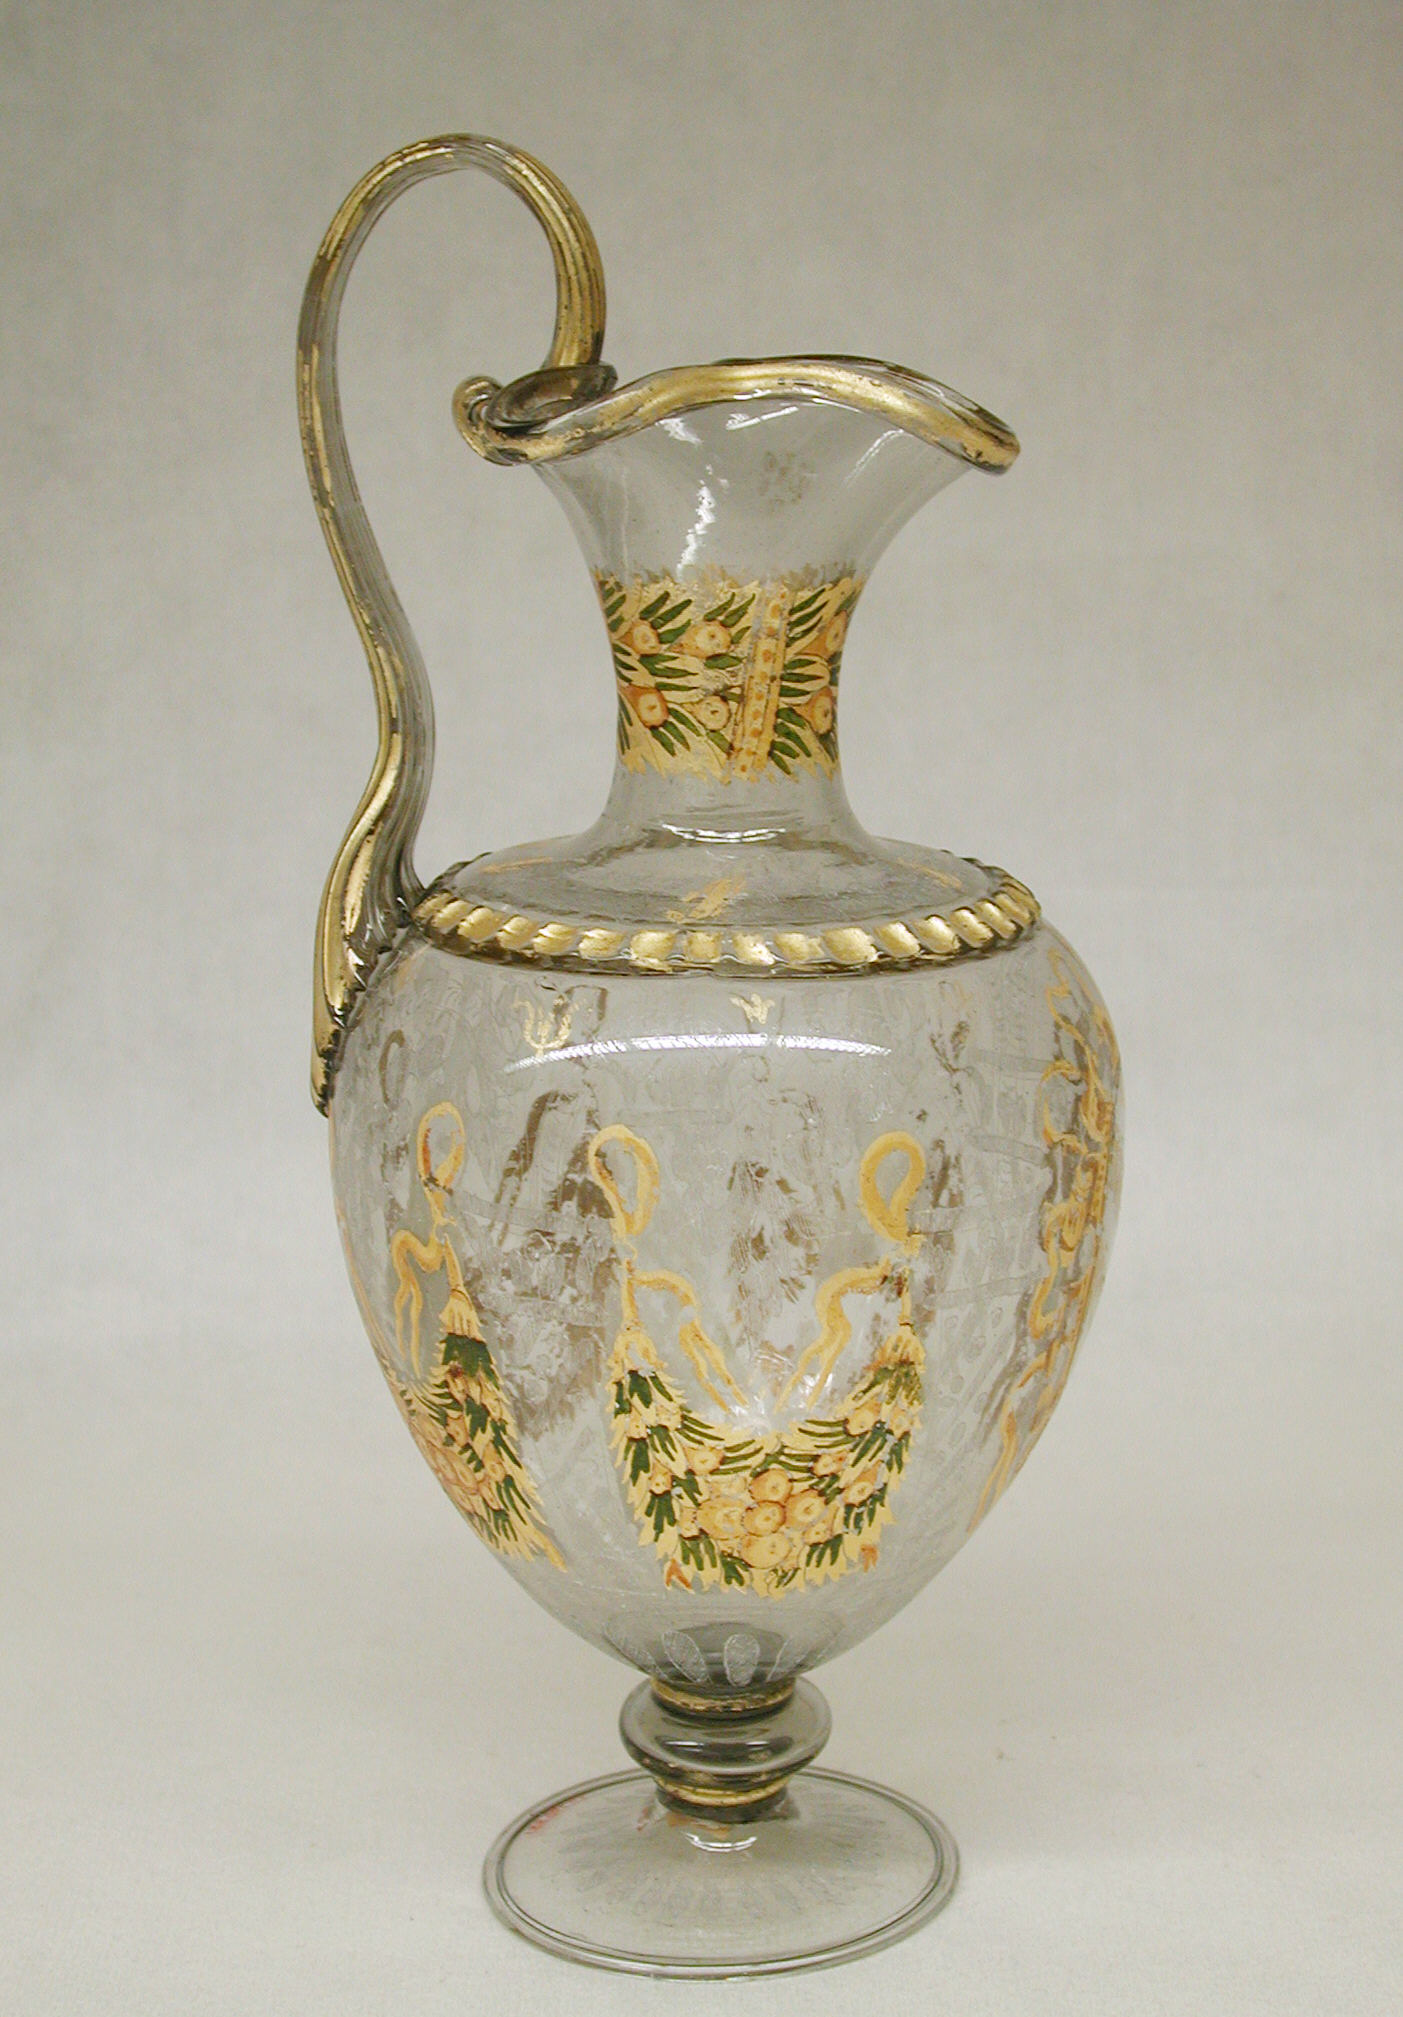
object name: ewer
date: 1570-1590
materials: gilt, glass, paint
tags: peacocks